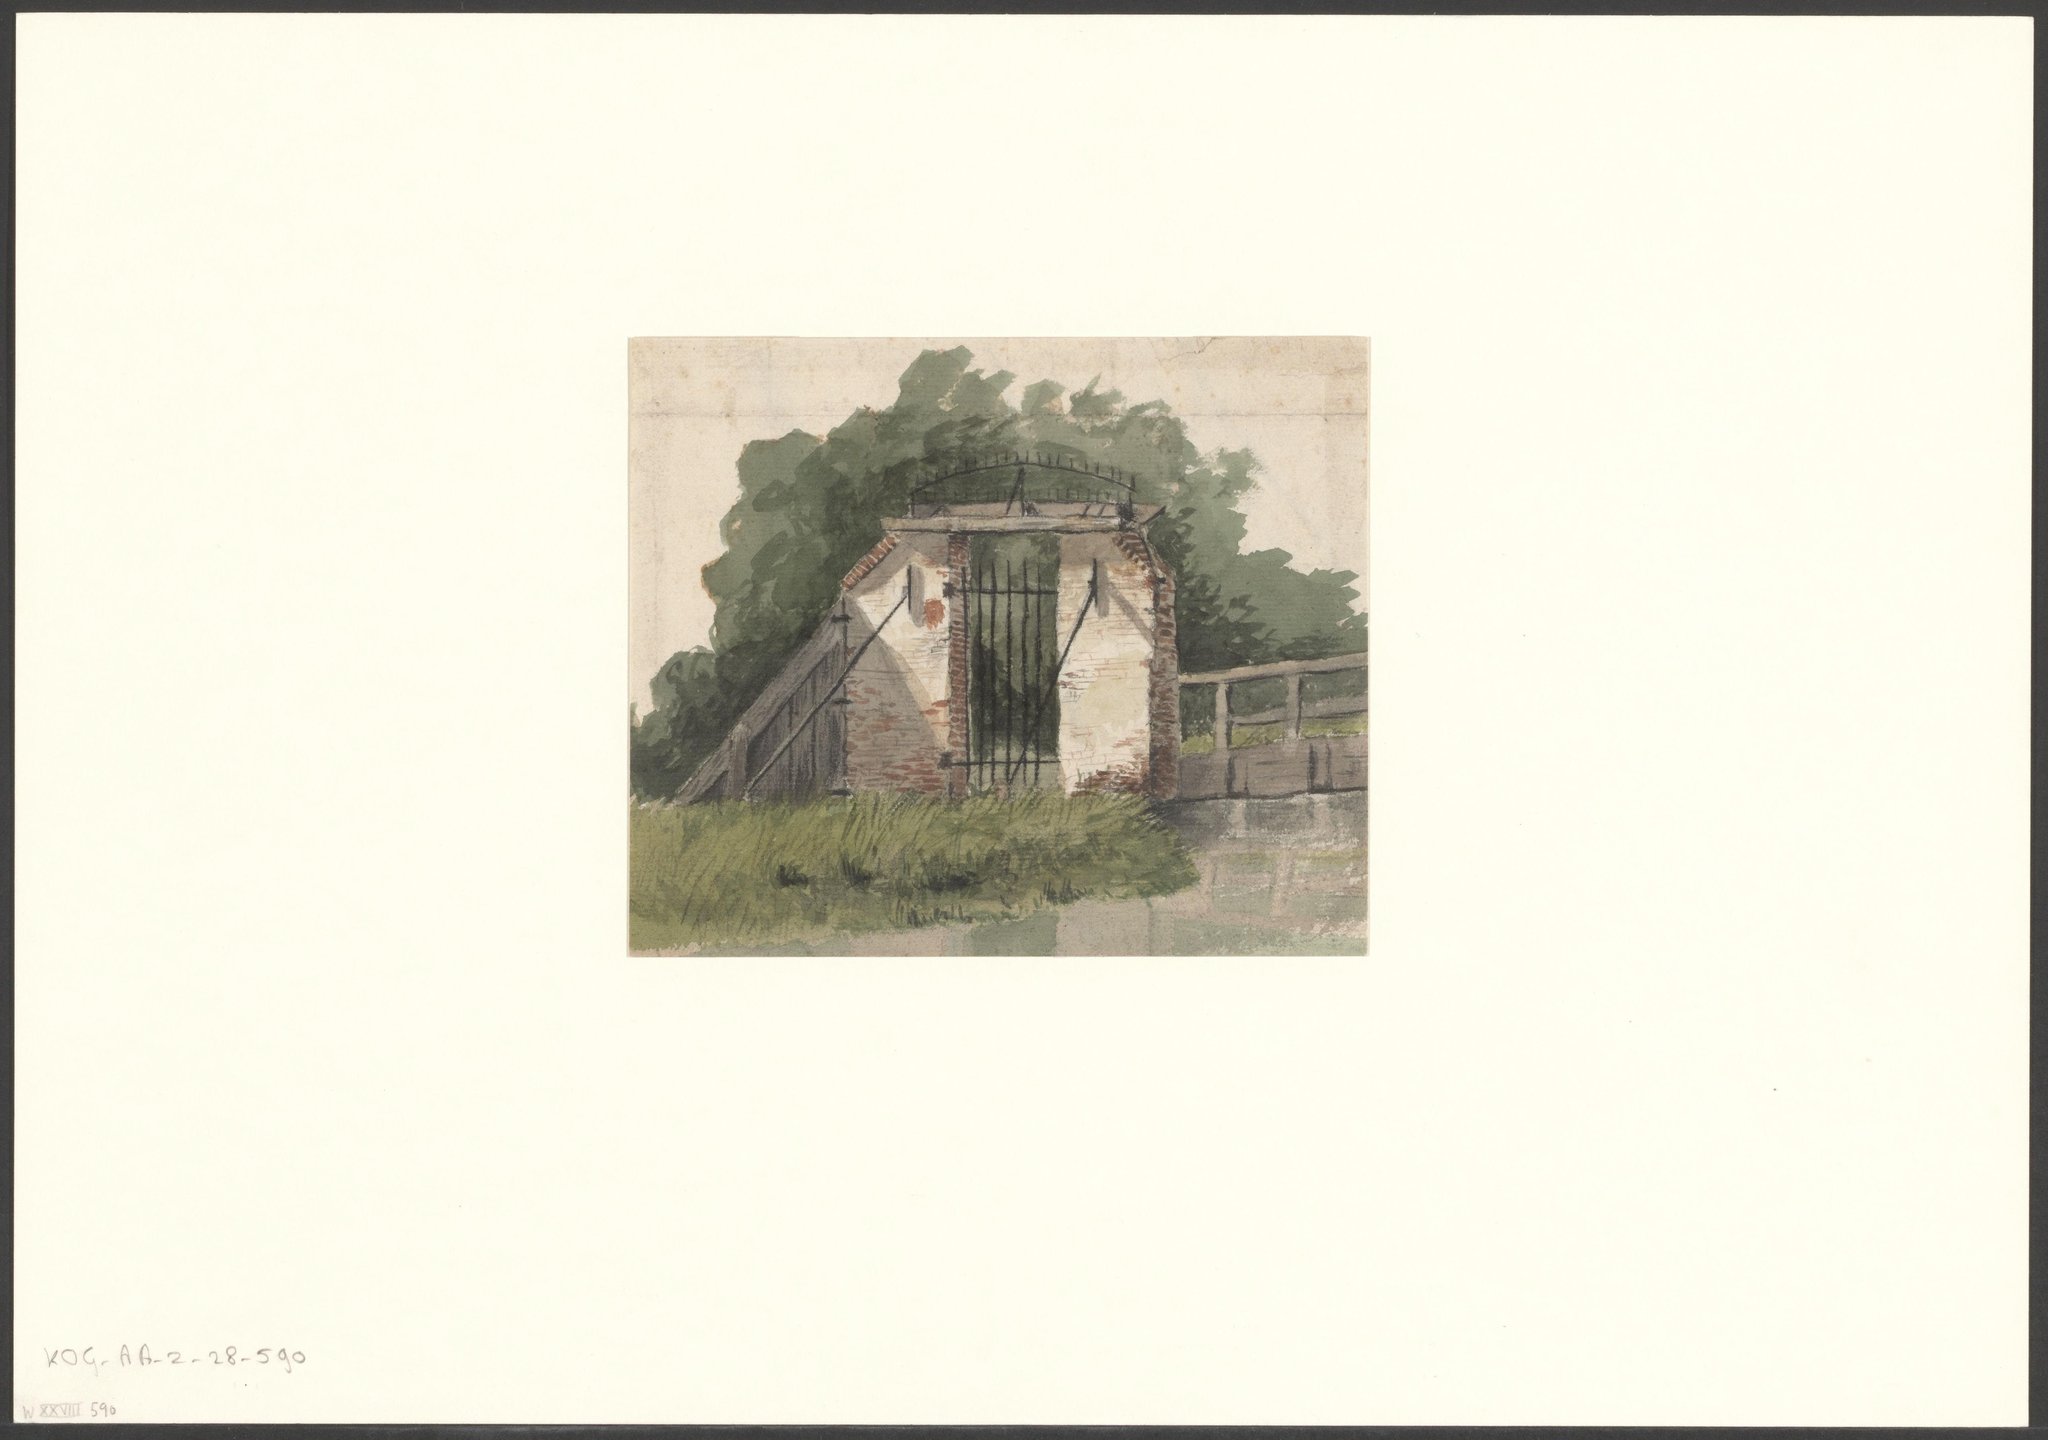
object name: drawing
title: Gezicht op de Singelgracht en de Raampoort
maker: anthonie van den bos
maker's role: draughtsman, print maker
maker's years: 1763-1838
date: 1773-1838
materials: chalk, gouache, paper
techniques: brush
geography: amsterdam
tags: city-view in general; 'veduta', small canal, ditch, city-gate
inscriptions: collector's mark: Lugt 800a, name: ‘A vd. Bos’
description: Tekening binnen de Atlas Van Eck ingedeeld op wijknummer 28.